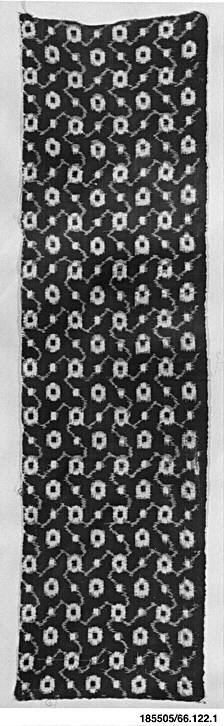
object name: piece of cloth for kimono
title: Piece of Cloth for Kimono with Pattern of Stylized Rosettes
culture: japanese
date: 1801-1900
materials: cotton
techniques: patterning, weave